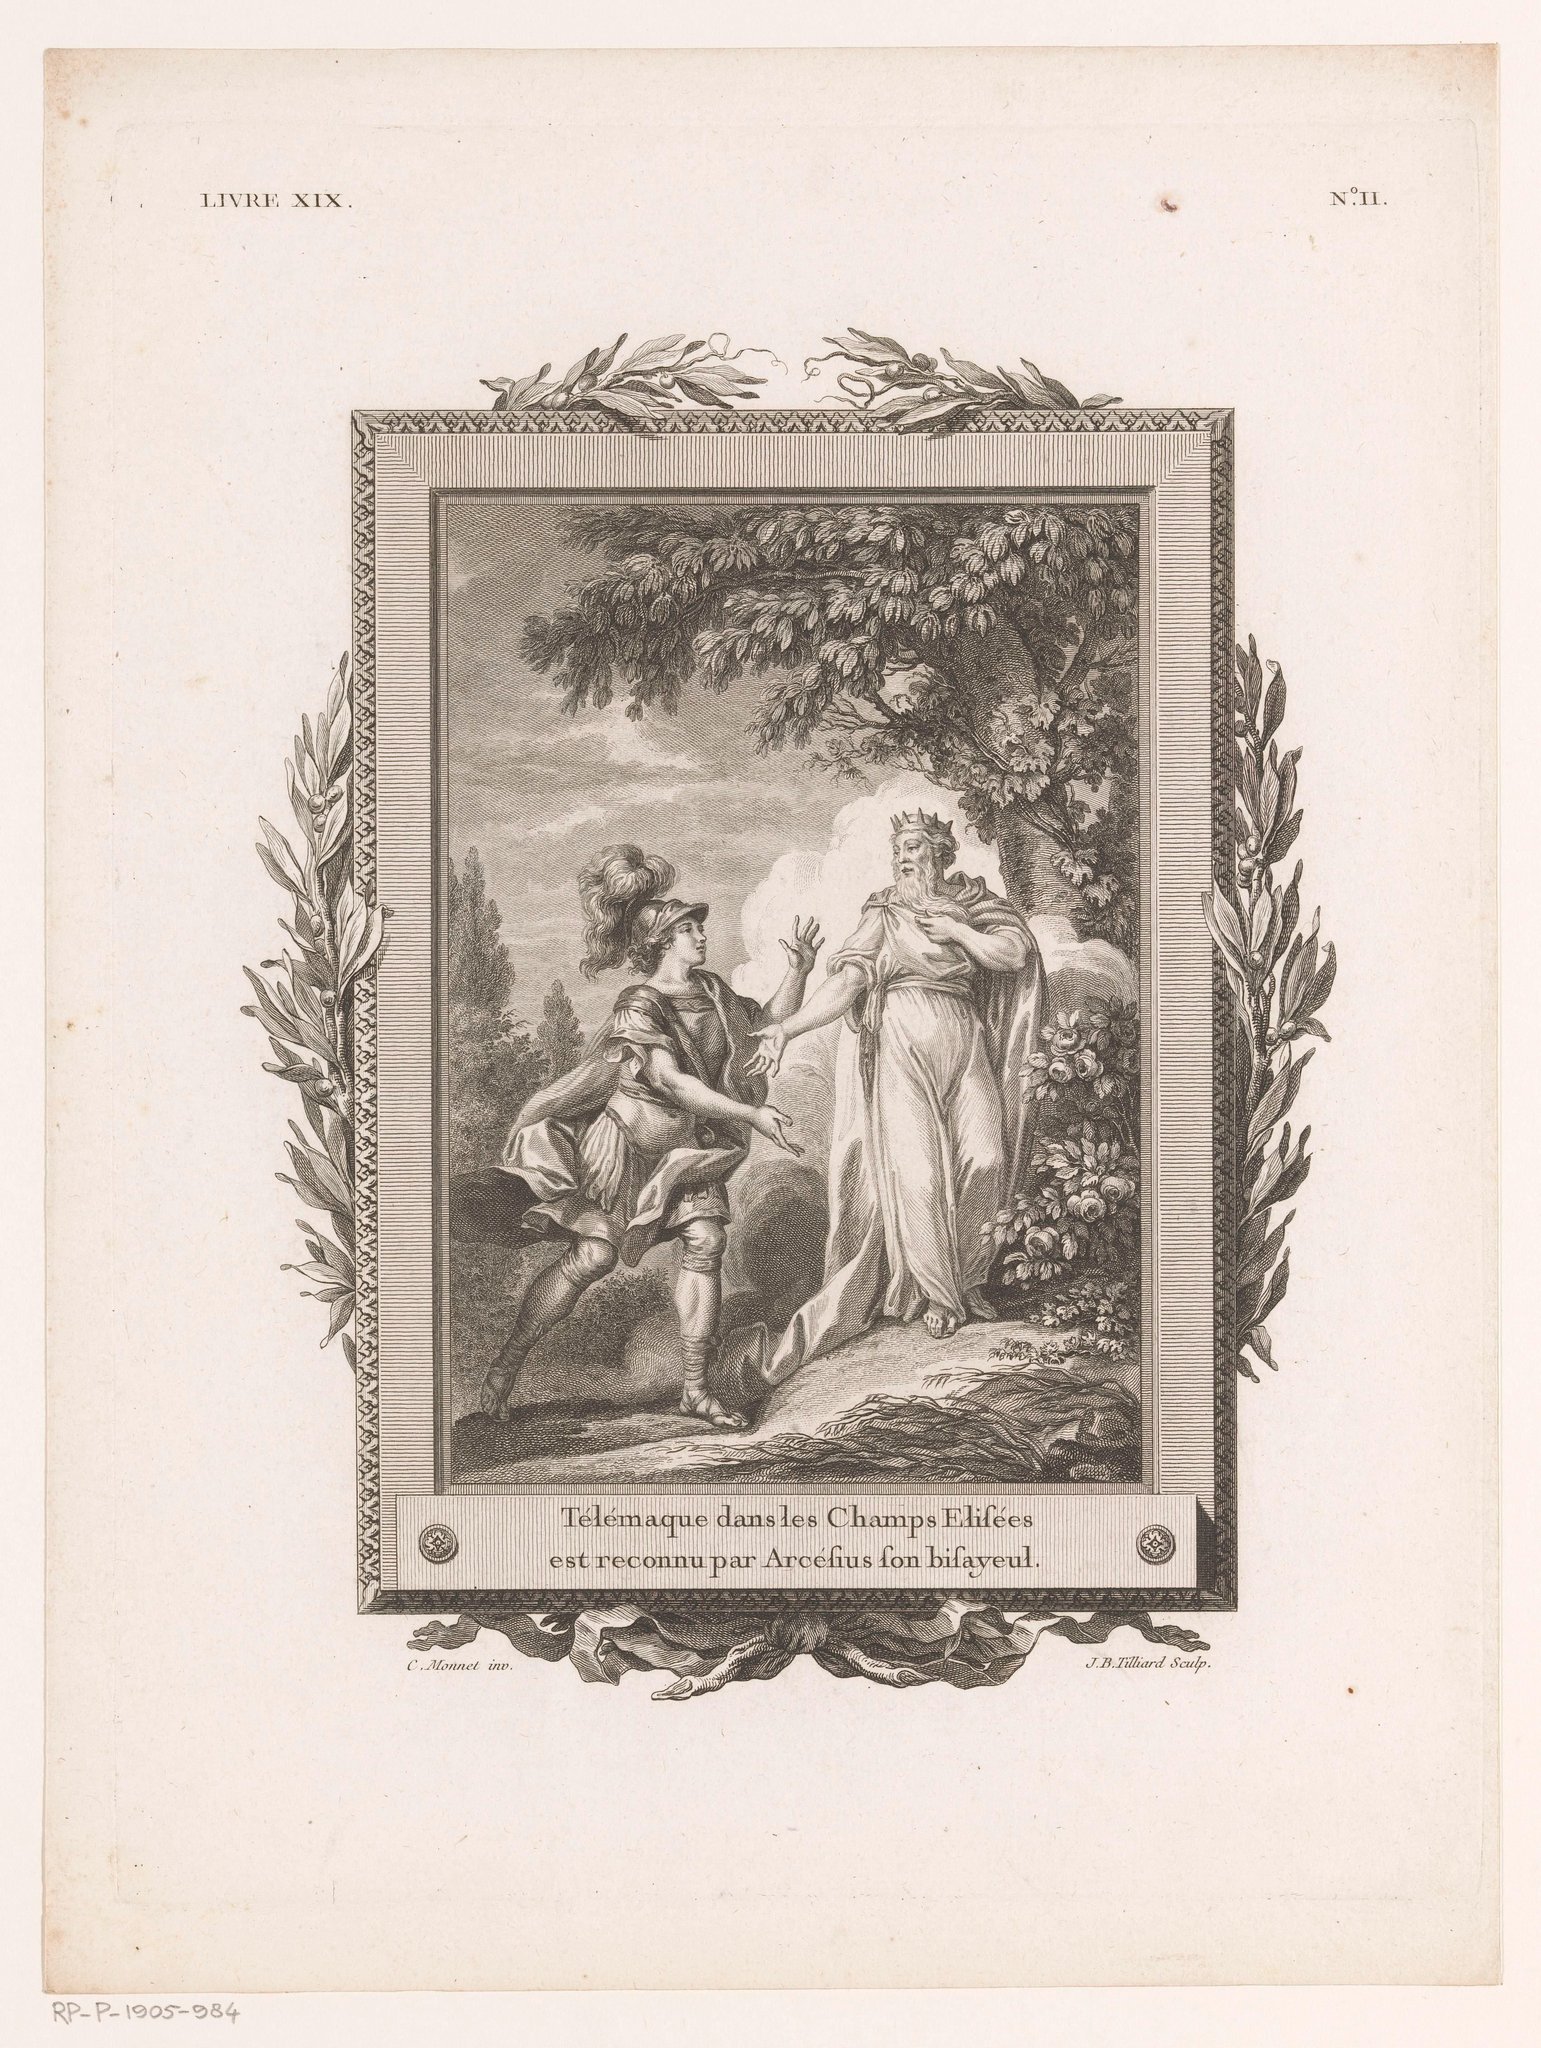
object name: print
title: Telemachus wordt herkend door zijn grootvader Arcelius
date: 1785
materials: paper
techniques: engraving, etching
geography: paris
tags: (fenelon, telemachus) specific works of literature (with author, title), (story of) telemachus, ornament ~ festoon, garland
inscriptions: collector's mark: Lugt 2228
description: Arcelius, staand onder een boom, herkent zijn kleinzoon Telemachus aan de linkerzijde. Het geheel wordt gekaderd door een sierlijst met olijftakken en onderaan een strik. Genummerd rechtsboven: No. II.